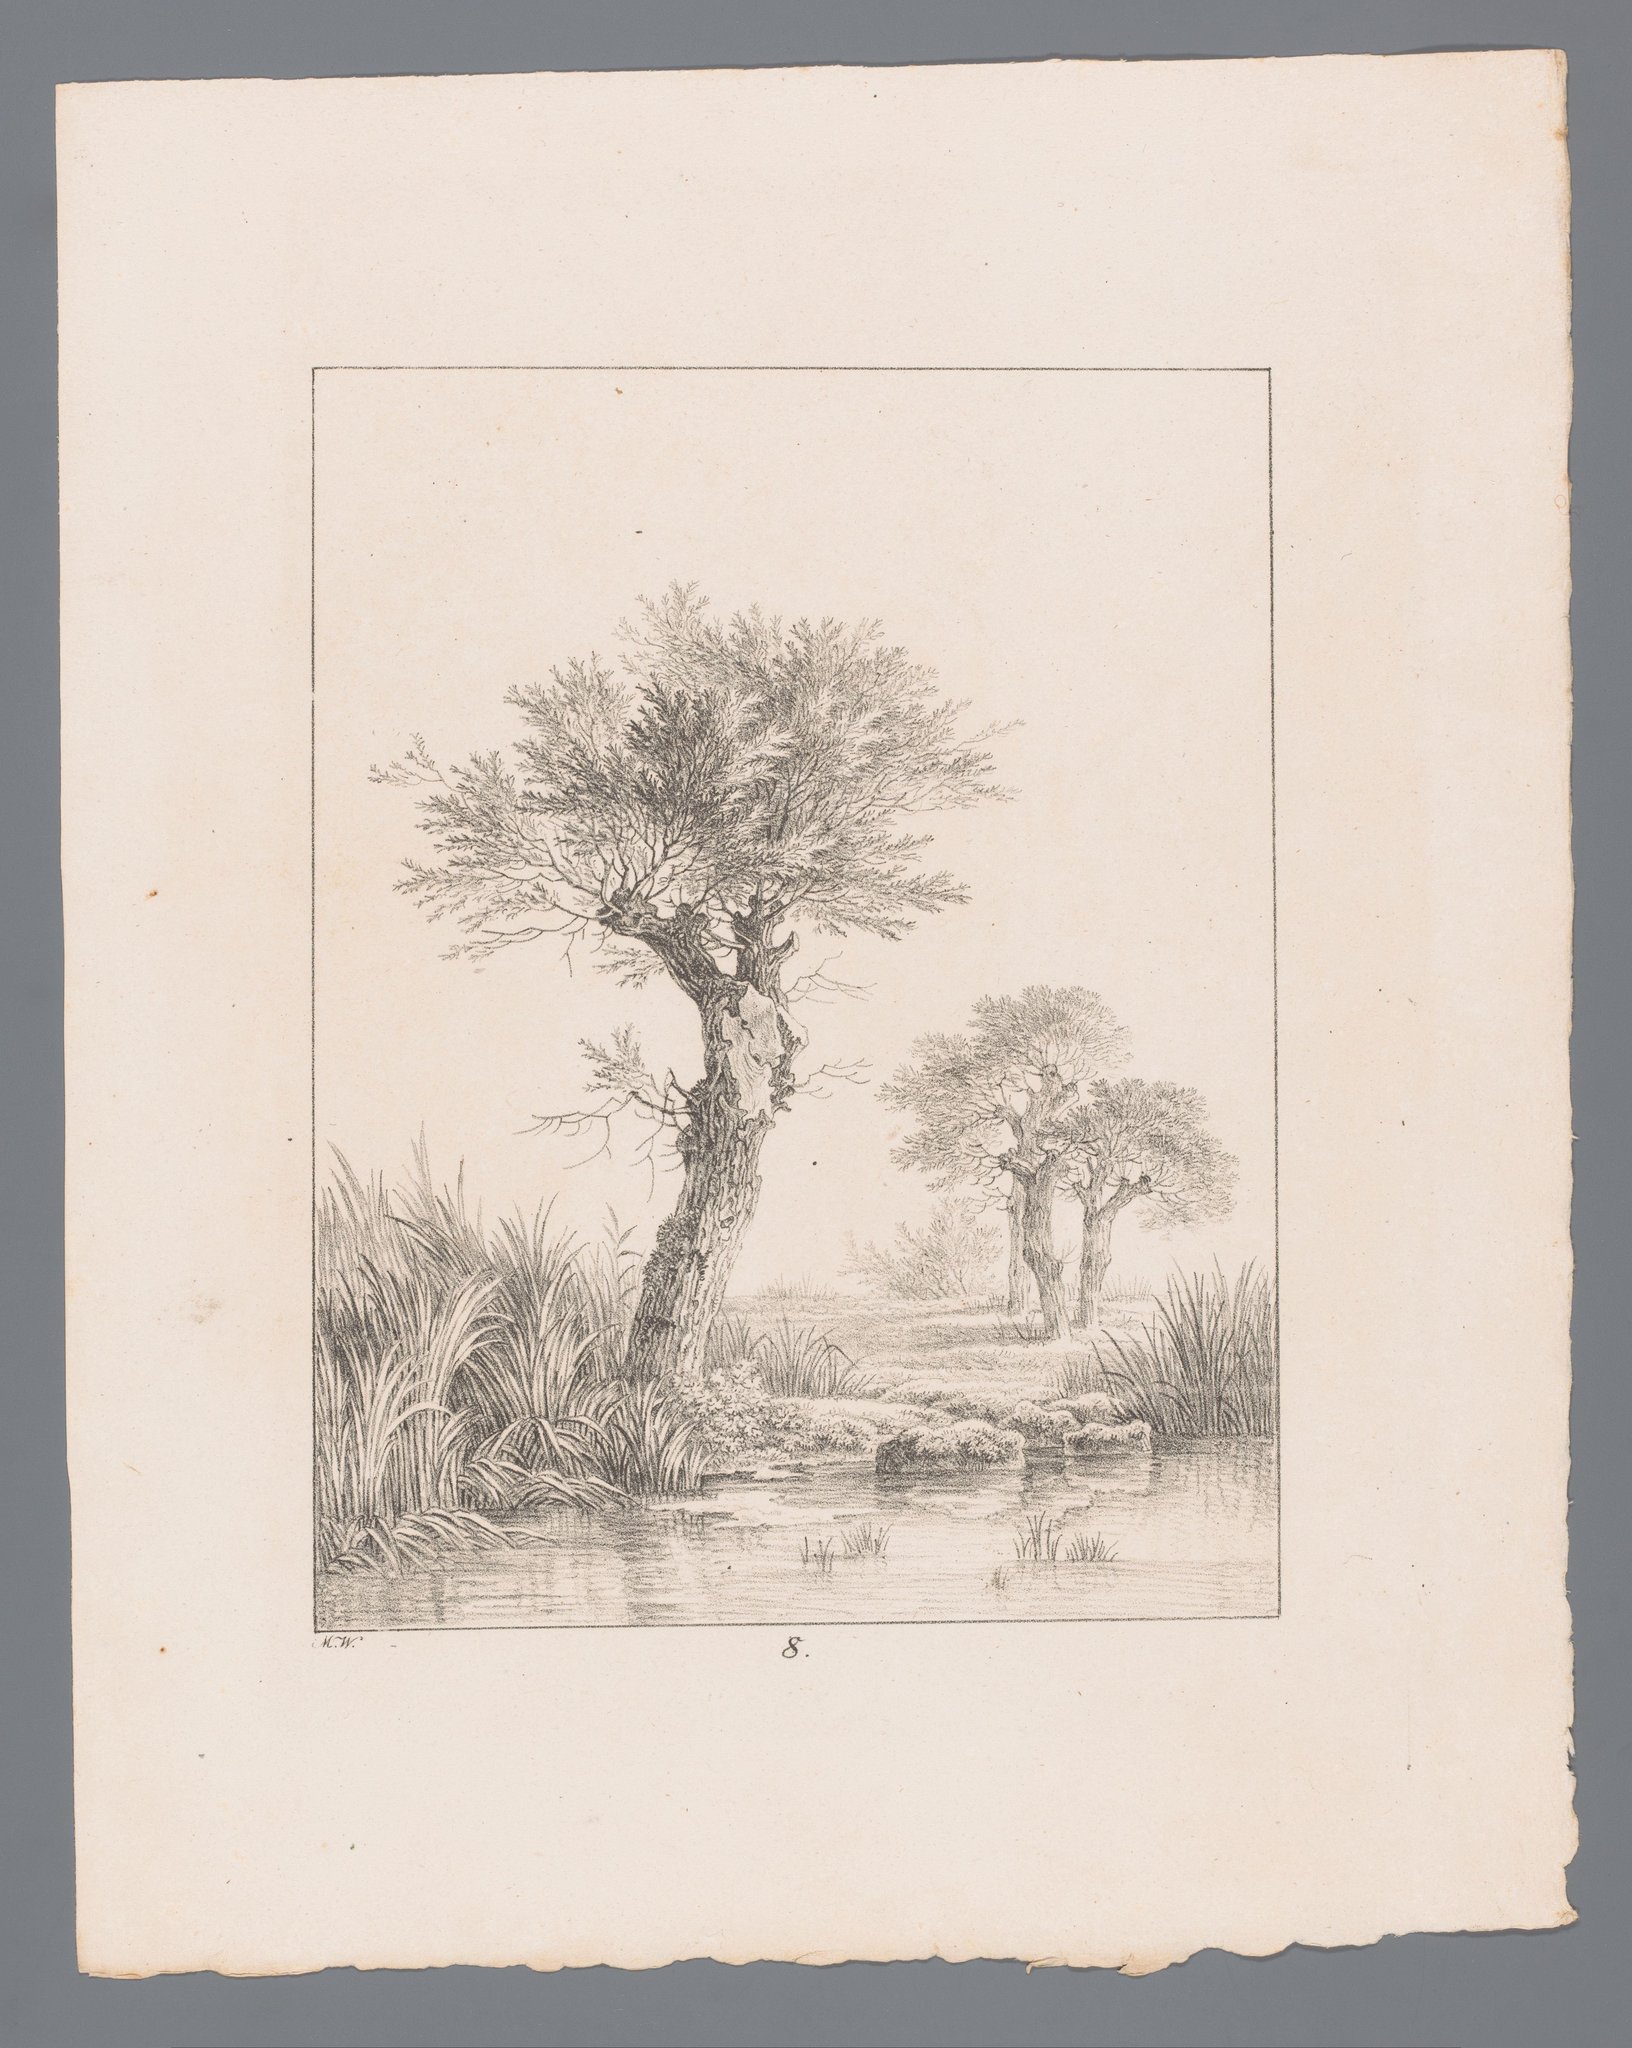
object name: print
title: Voorbeelden voor de landschapstekenaar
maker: max josef wagenbauer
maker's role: print maker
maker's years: 1774-1829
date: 1823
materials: paper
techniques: lithograph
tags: trees, river bank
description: Onderdeel van een tweedelige serie waarvan het eerste deel bestaat uit een titelprent en twintig voorstellingen van takken, bladeren, bomen en landschappen.